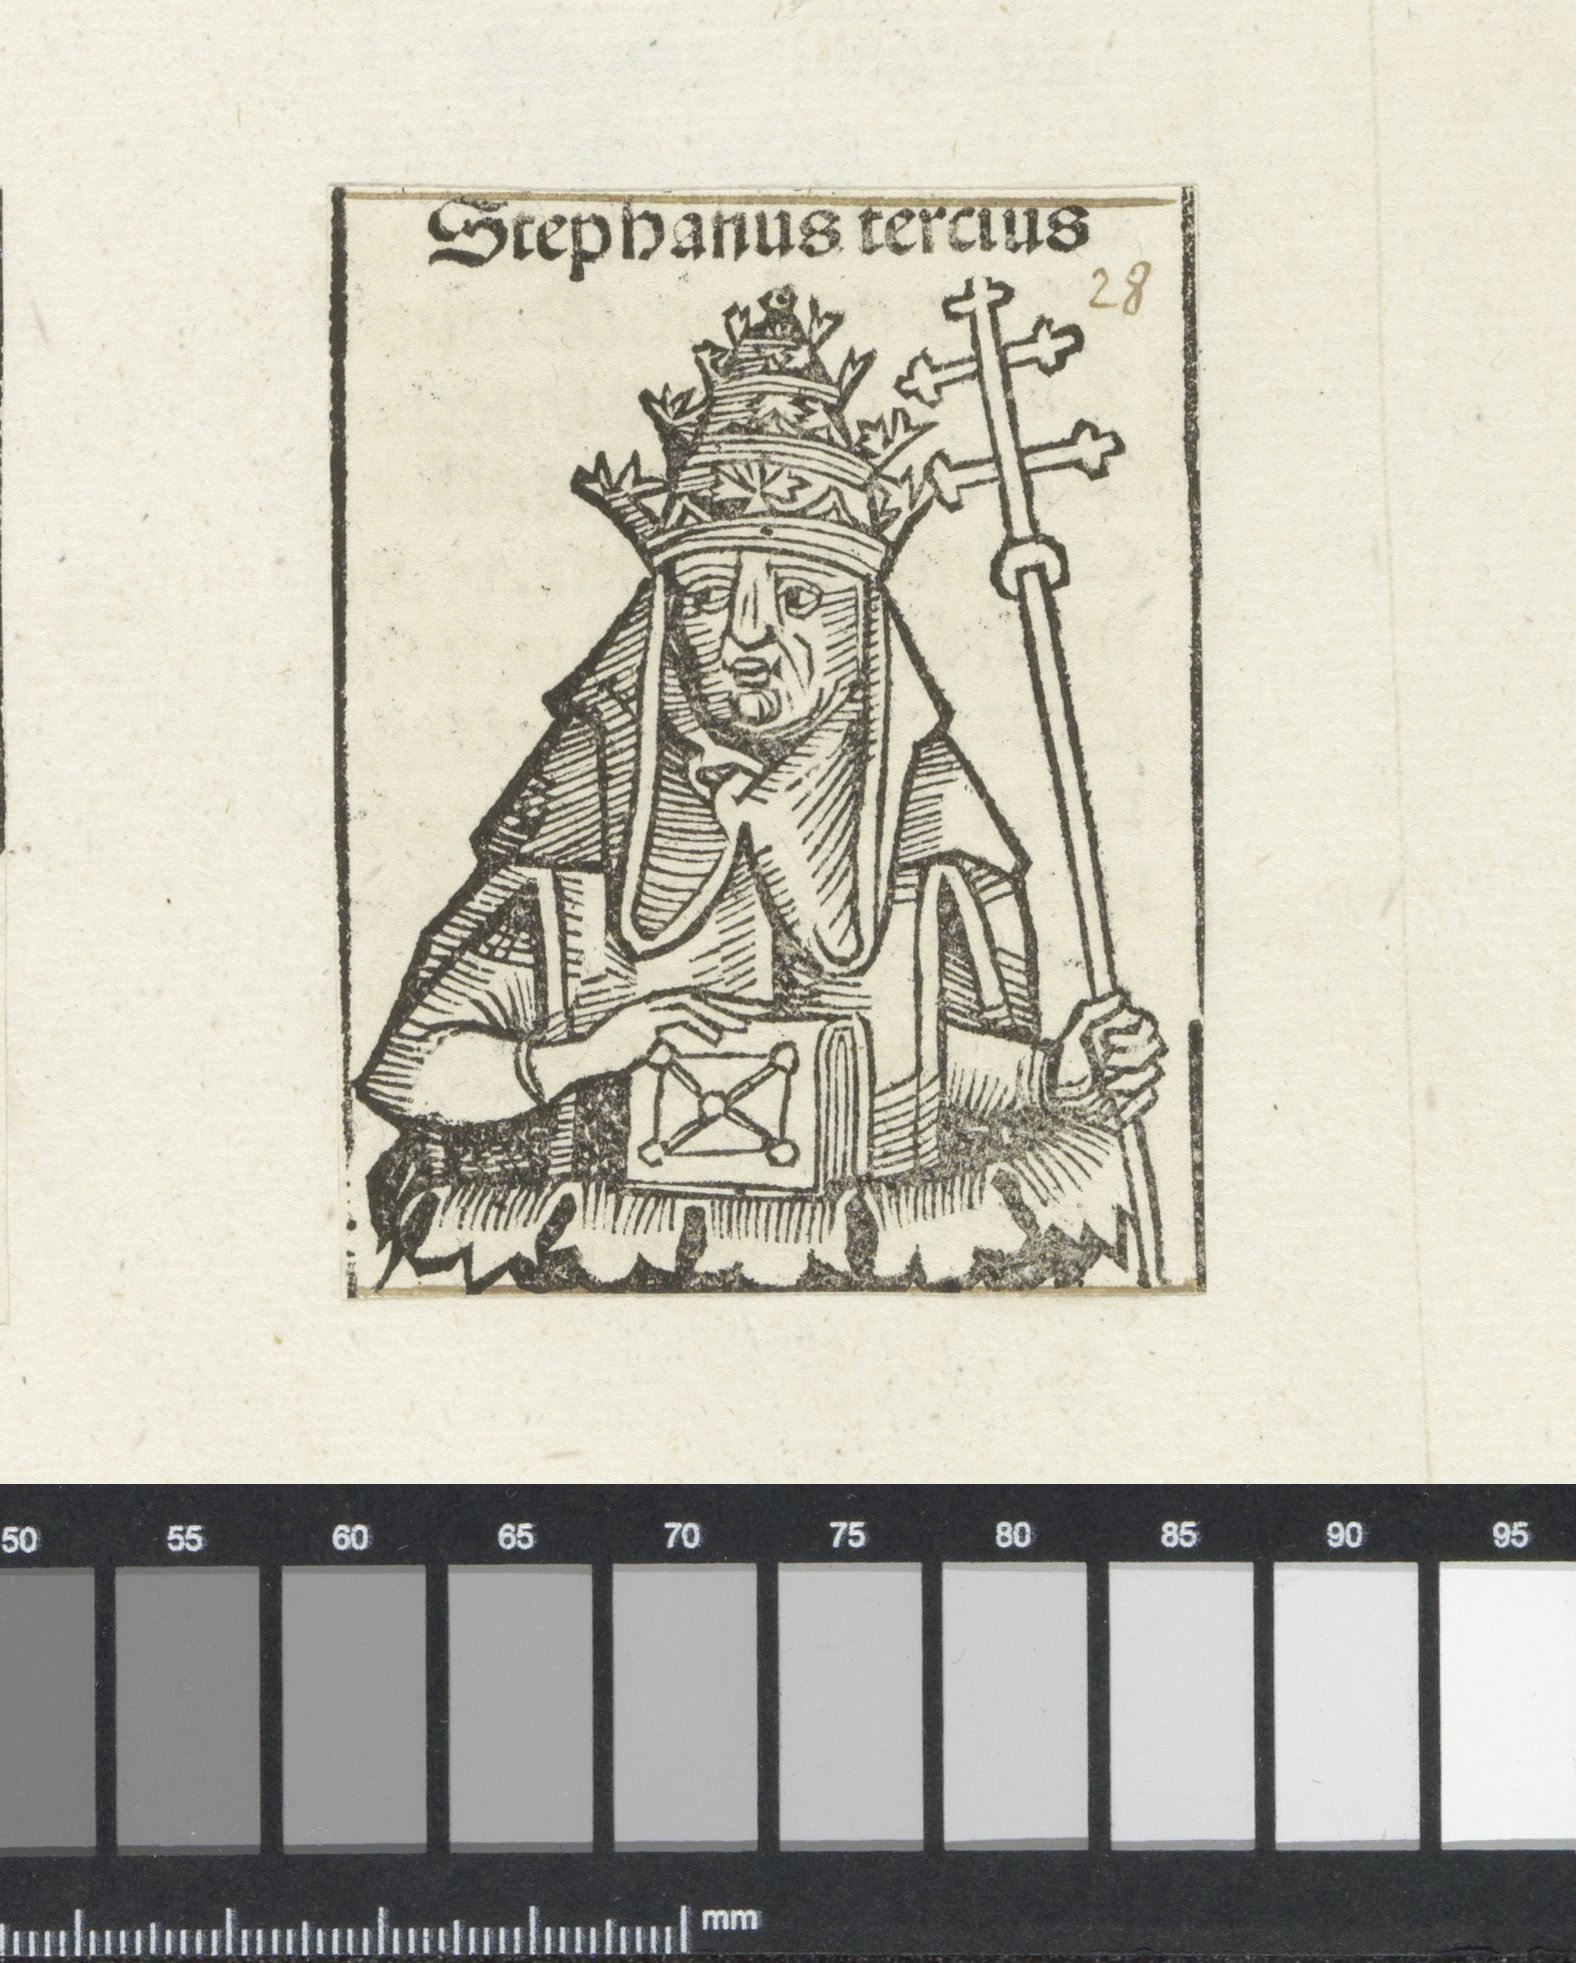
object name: album leaf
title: Stephanus tercius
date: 1493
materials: paper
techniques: letterpress printing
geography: nuremberg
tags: pope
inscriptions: inscription: ‘28’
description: Een bloemkelk met een paus. Hij draagt een tiara en heeft een bijbel en een staf met een dubbel kruis in zijn handen. De voorstelling is onderdeel van de opeenvolging pausen in de Liber Chronicarum. De tekst identificeert de man als paus Stefanus III. De prent maakt deel uit van een album.